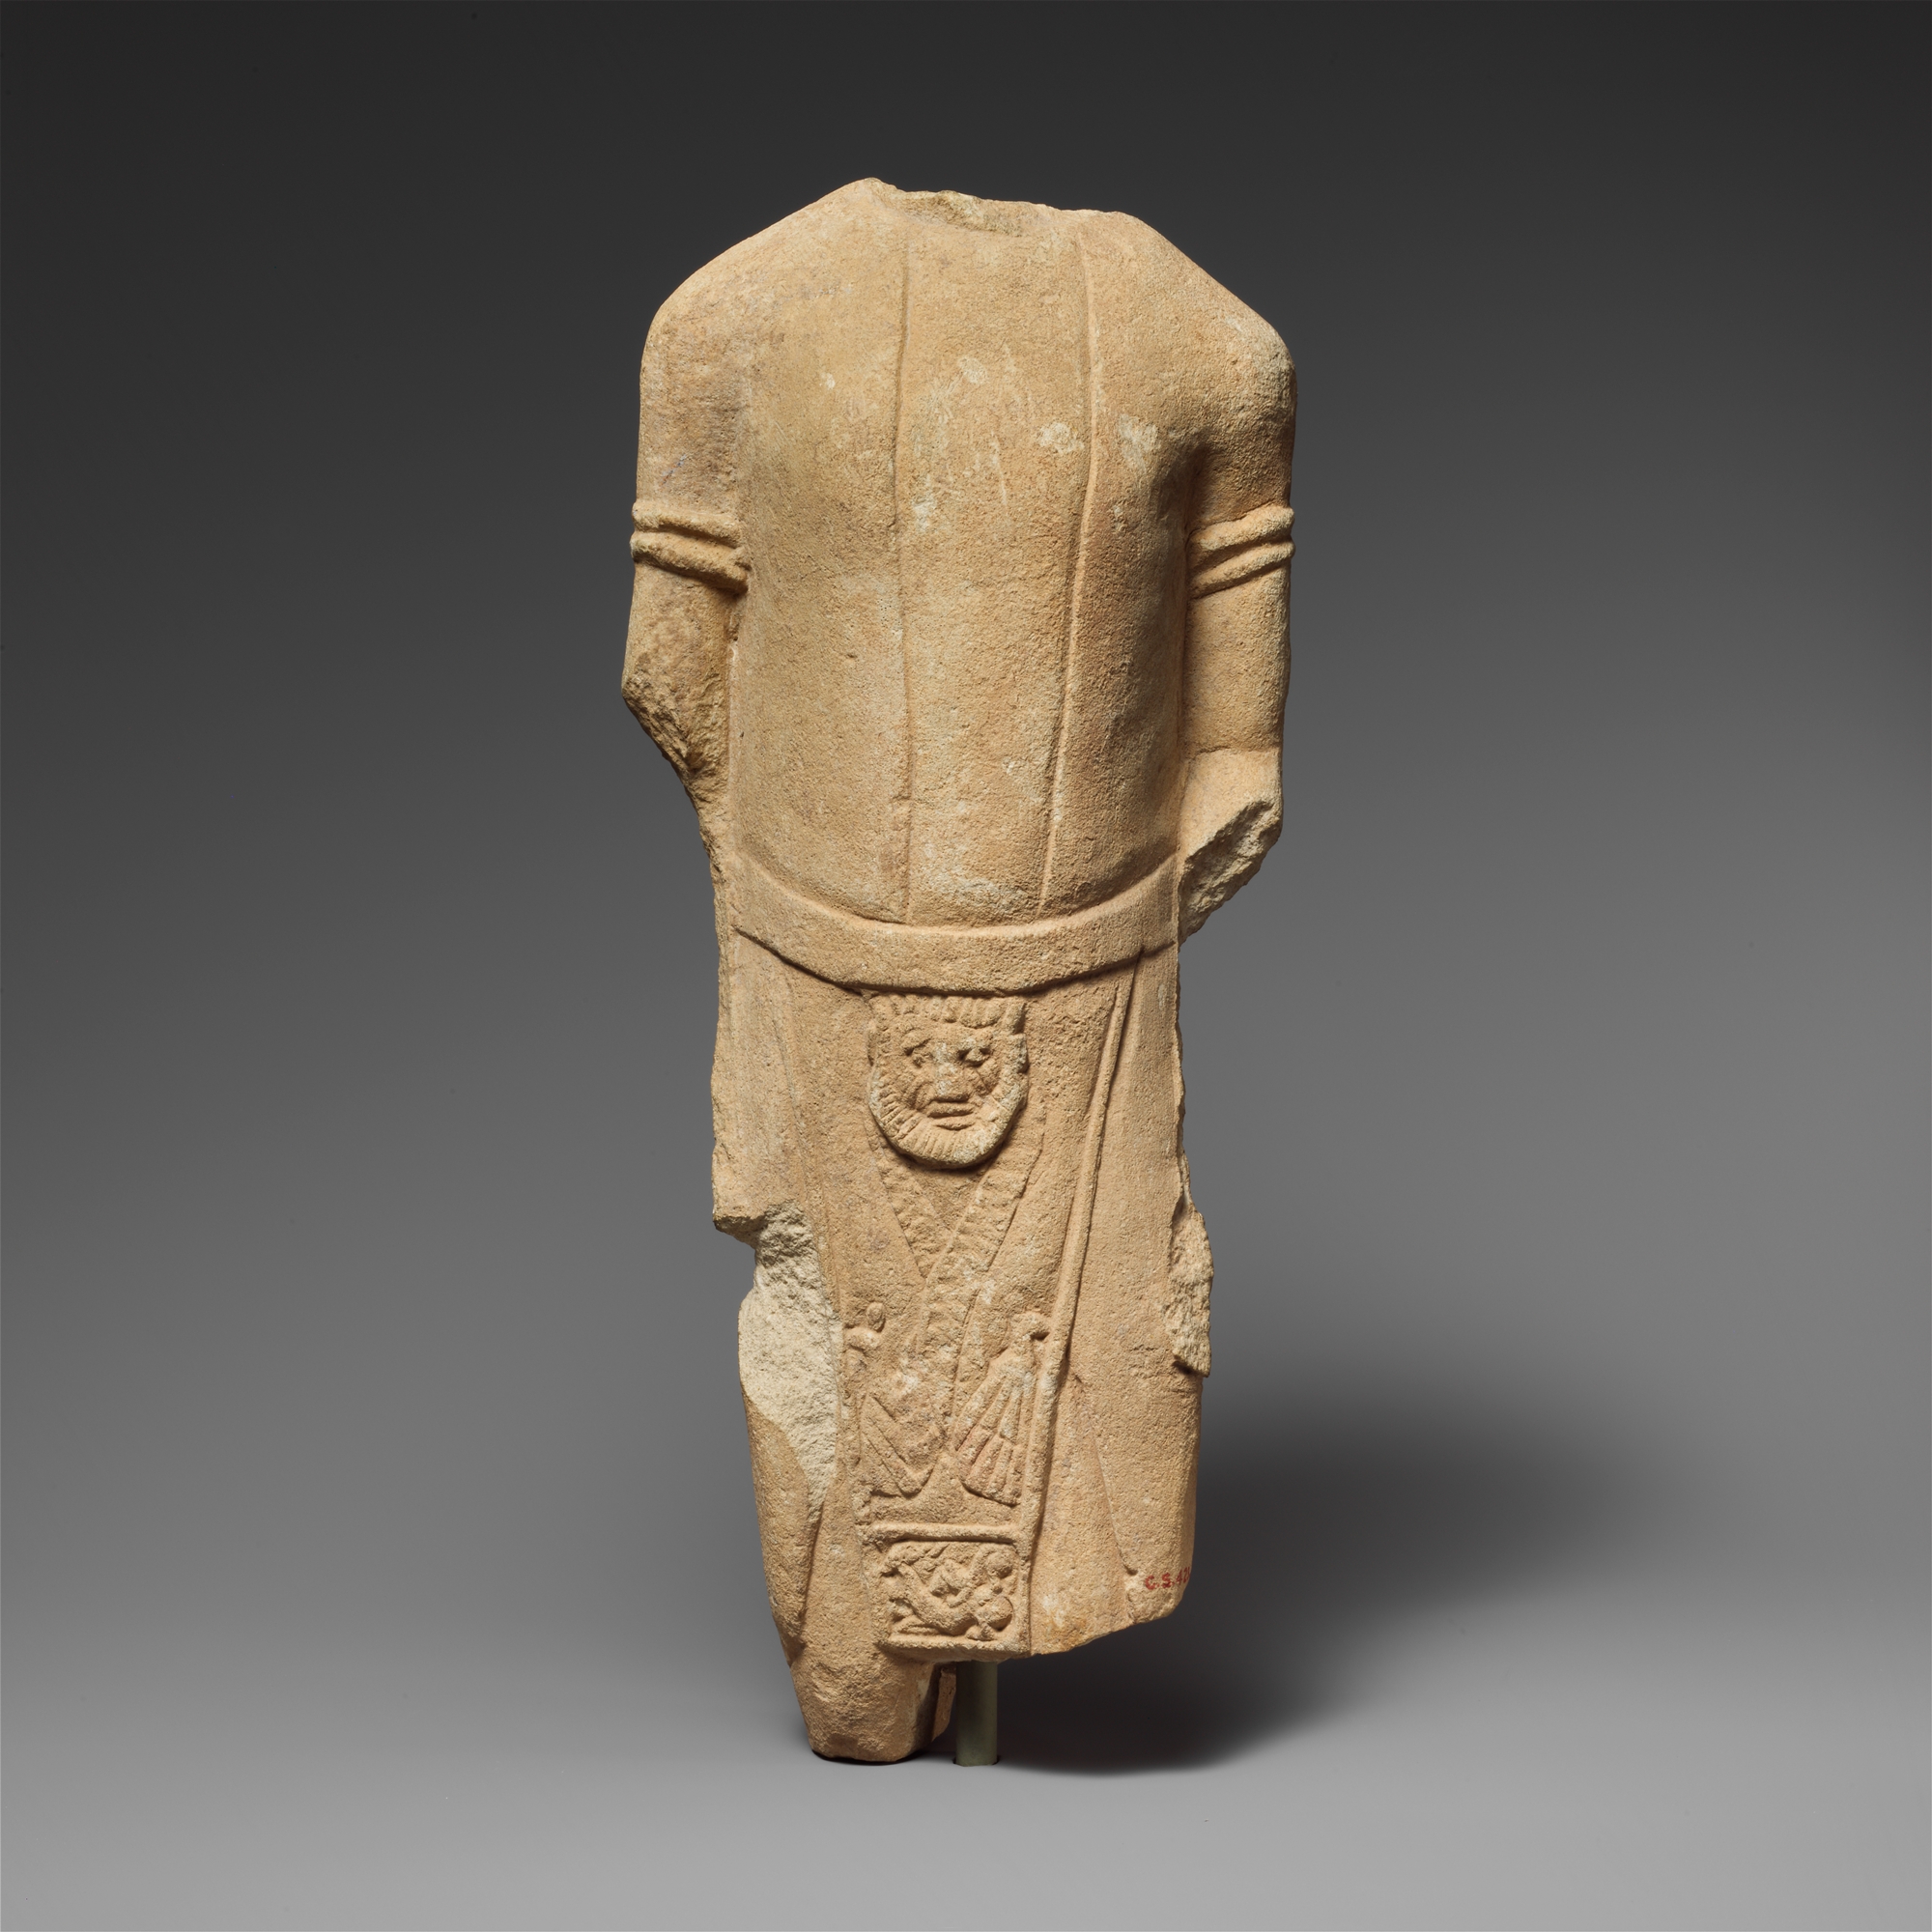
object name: statue of a votary, male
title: Limestone statuette of a male votary in Egyptianizing dress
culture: cypriot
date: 500-468 BCE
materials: limestone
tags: men